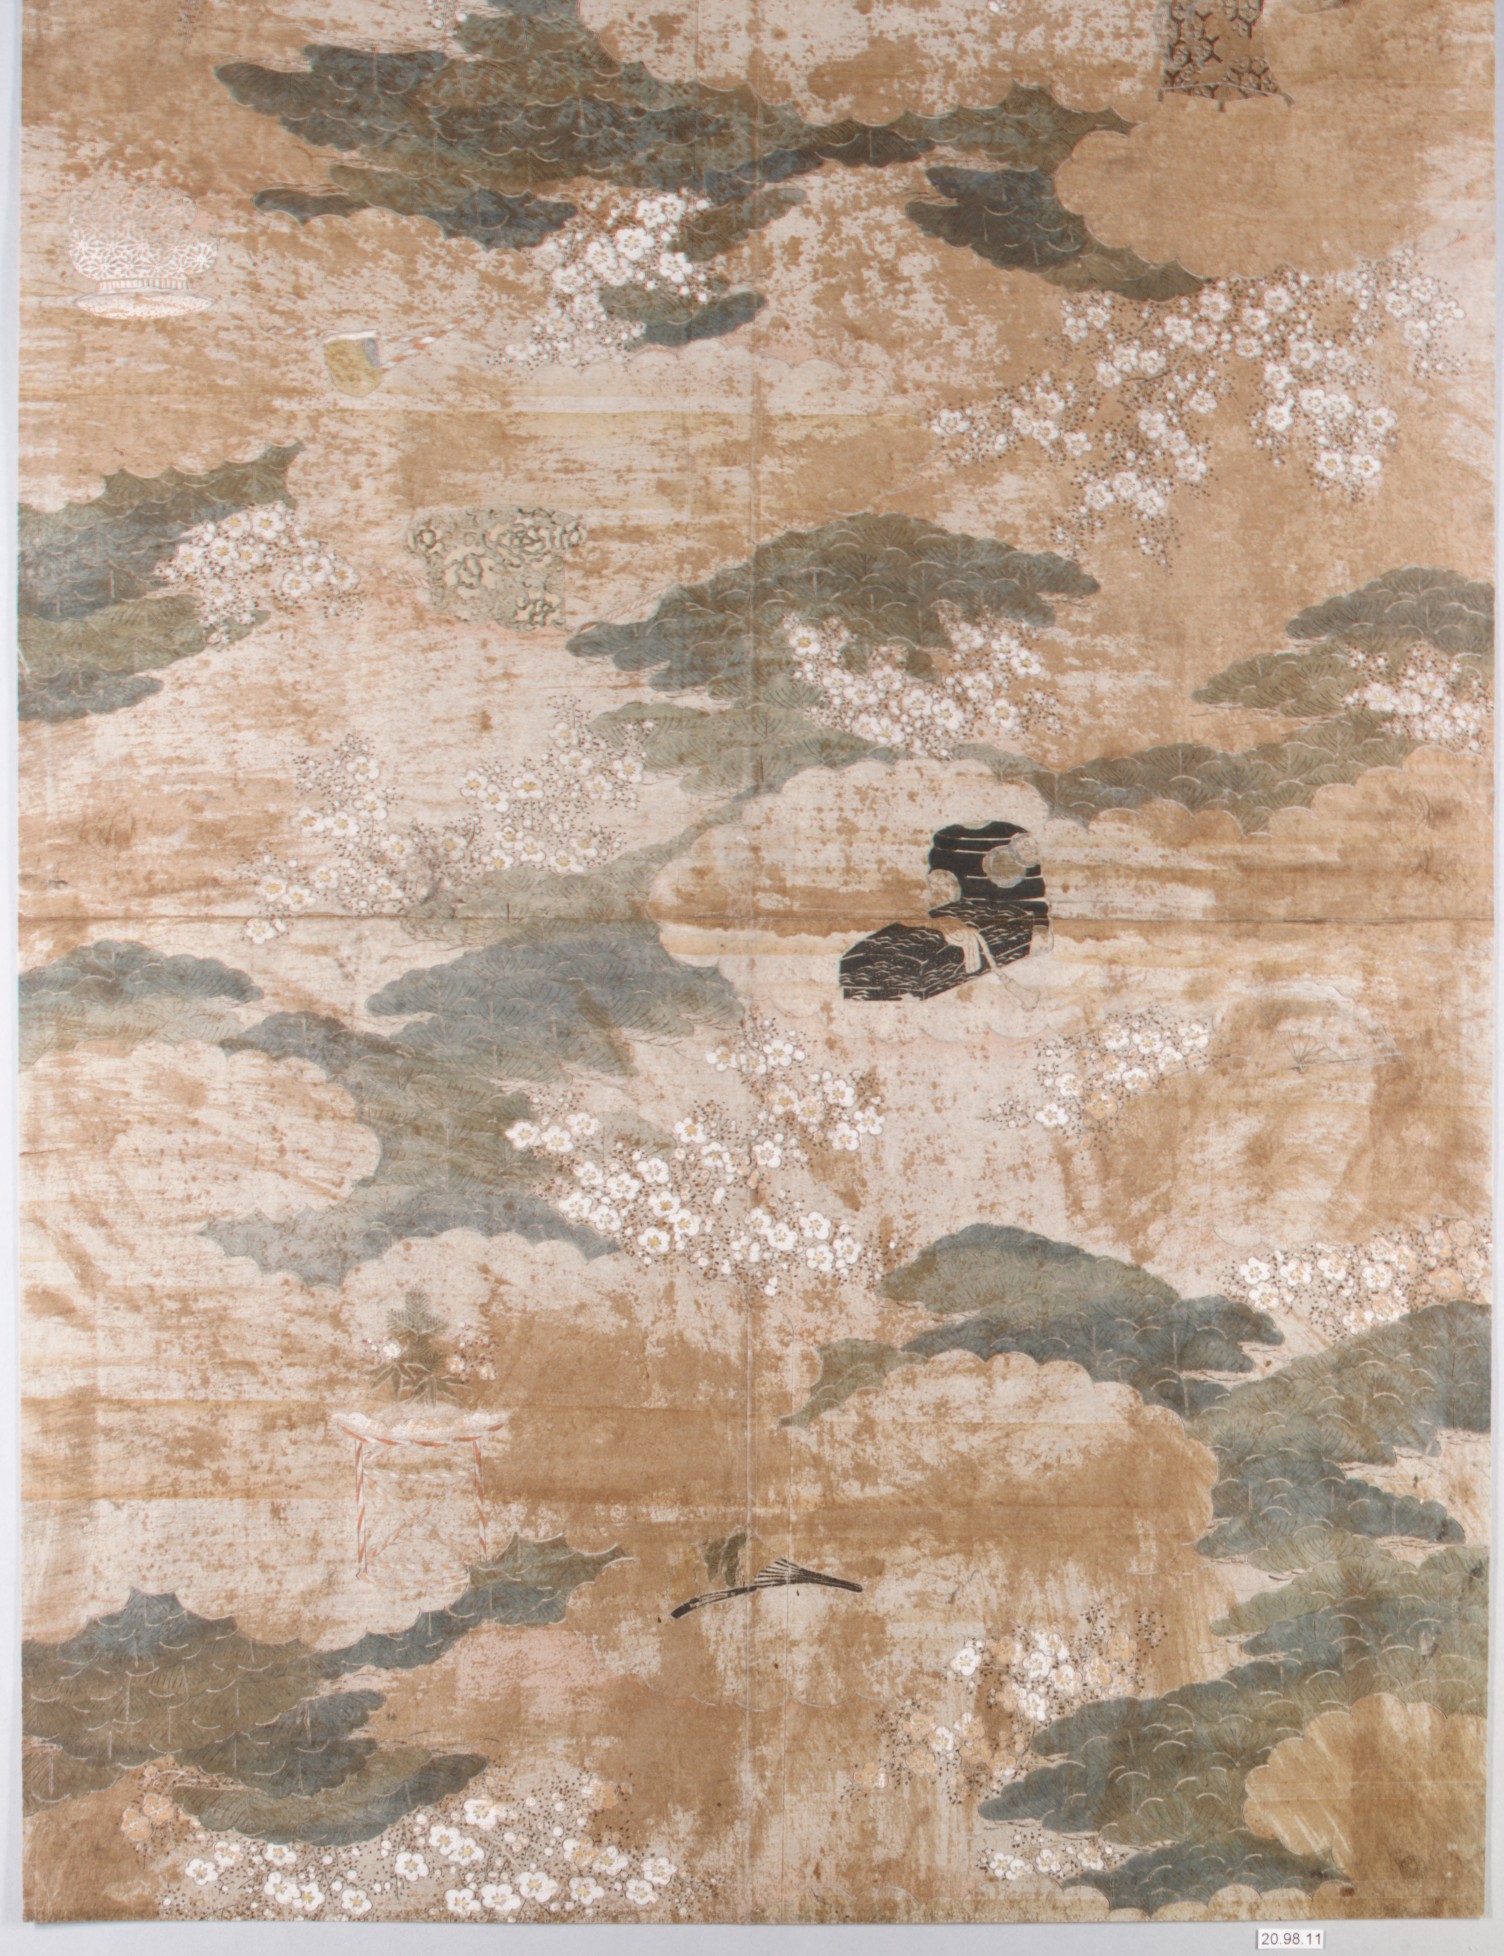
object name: textile design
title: Textile Design for Stencil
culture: japanese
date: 1601-1700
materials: paint, paper